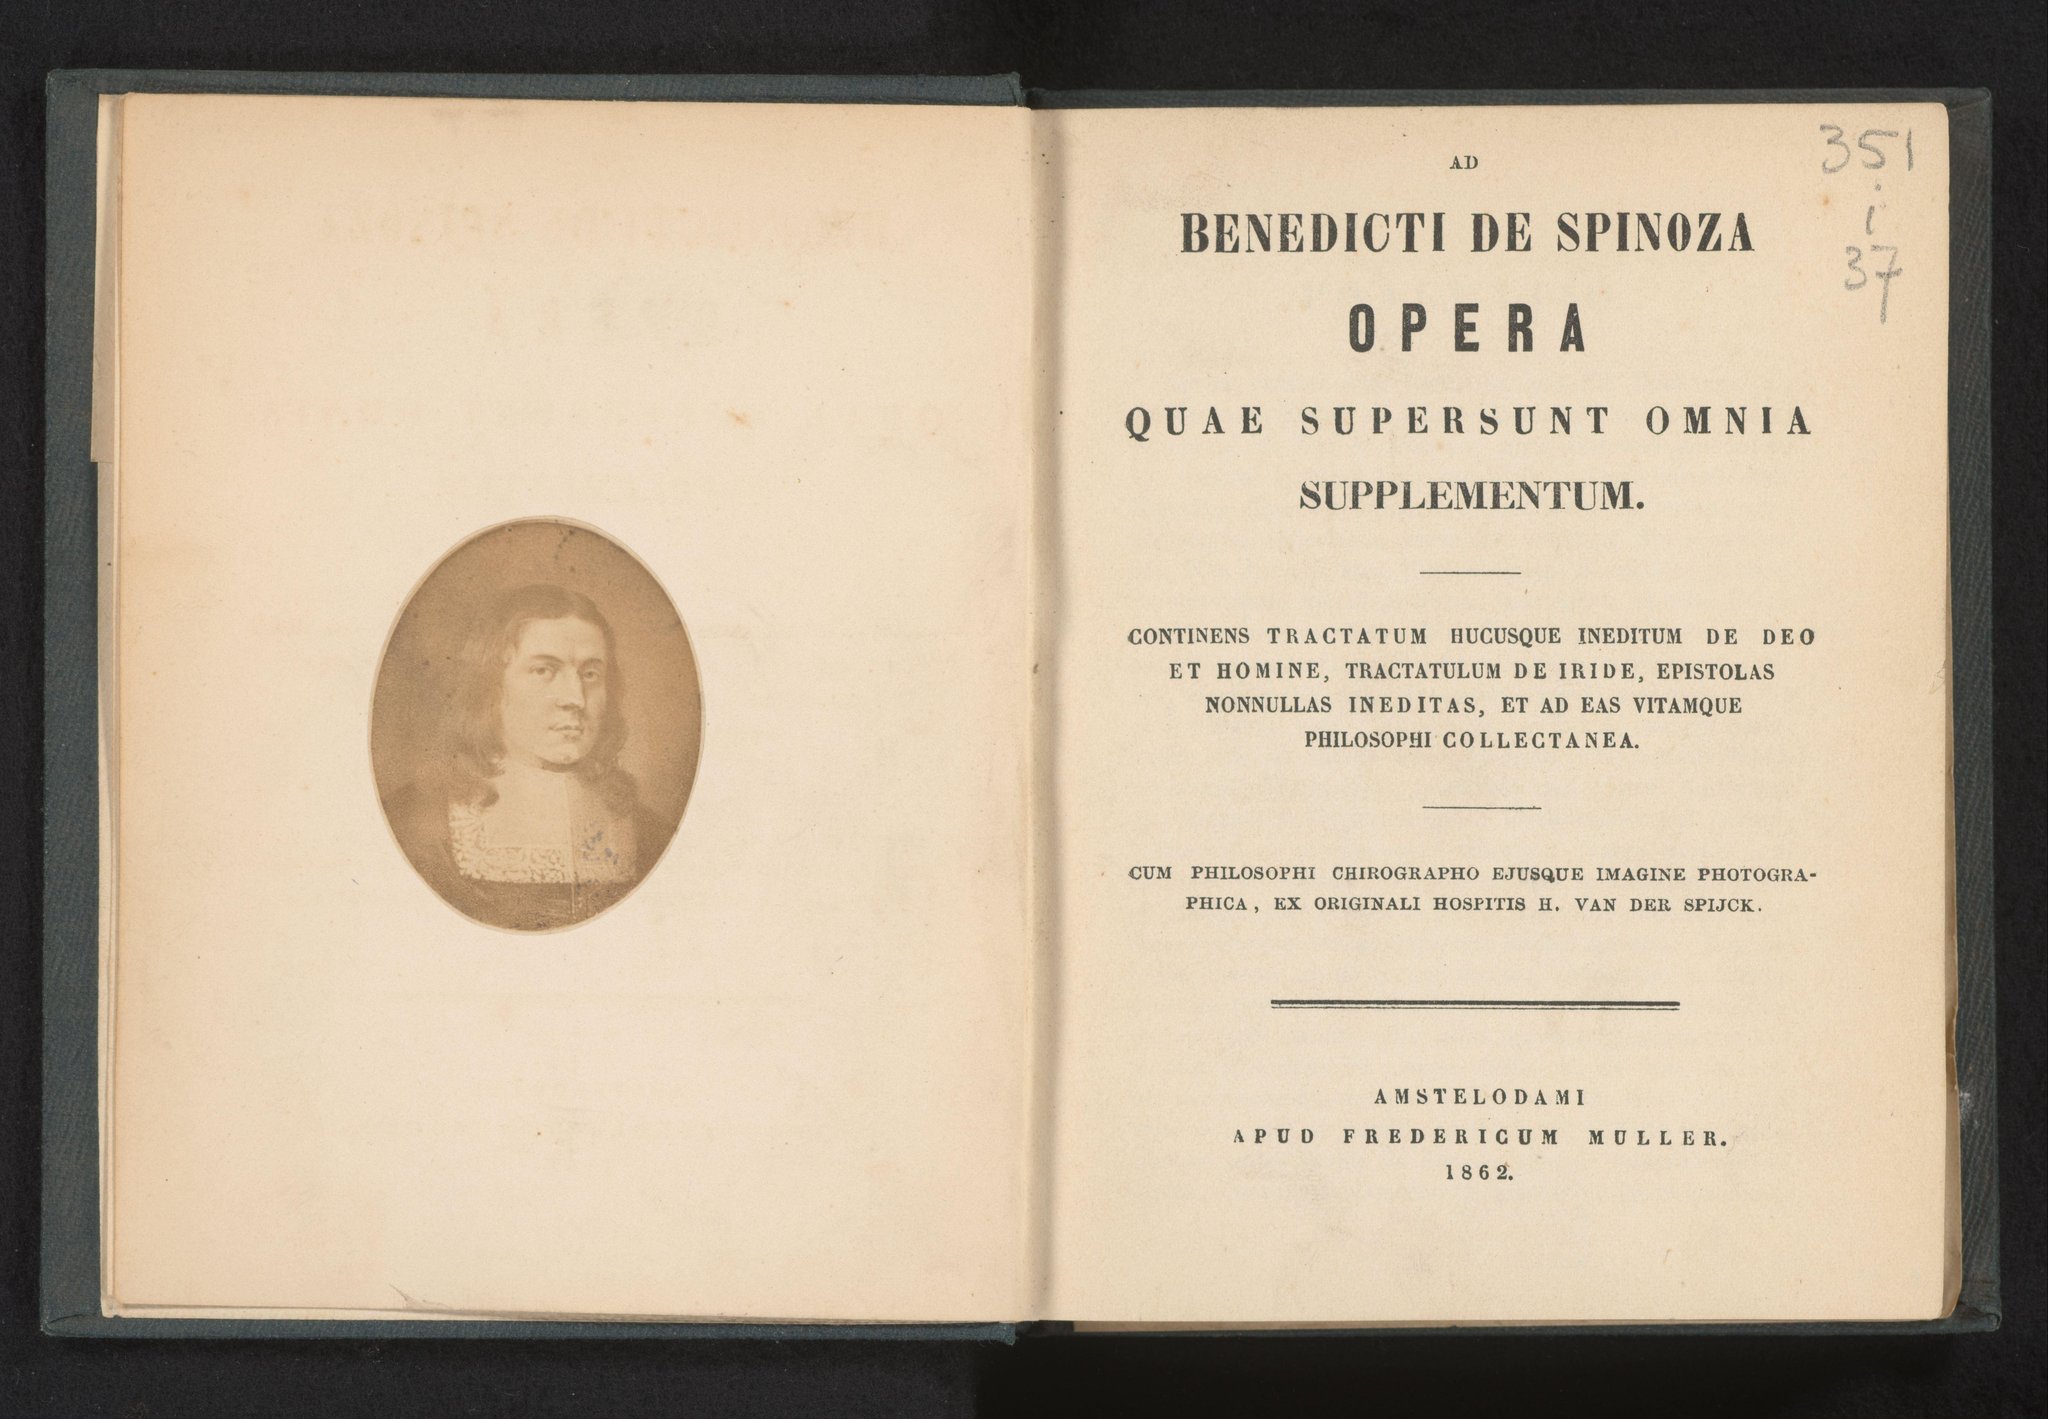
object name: book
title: Ad Benedicti de Spinoza opera quae supersunt omnia supplementum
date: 1862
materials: cardboard, paper, textile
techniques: albumen print, letterpress printing, lithograph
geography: amsterdam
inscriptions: inscription: ‘45,-/ I/62/ x) front. photograph/ x) bookplate Grisebach/ Di-t parallel text/ x) C in Astedm./ x) Fred. Müller publication!’, bookplate: ‘Ex Libris/ Eduard Grisebach’, retailer's mark: ‘Dr. H. Lüneburg & Co./ Sortiment-Antiquariat/ München/ Maximilianspl. 3’